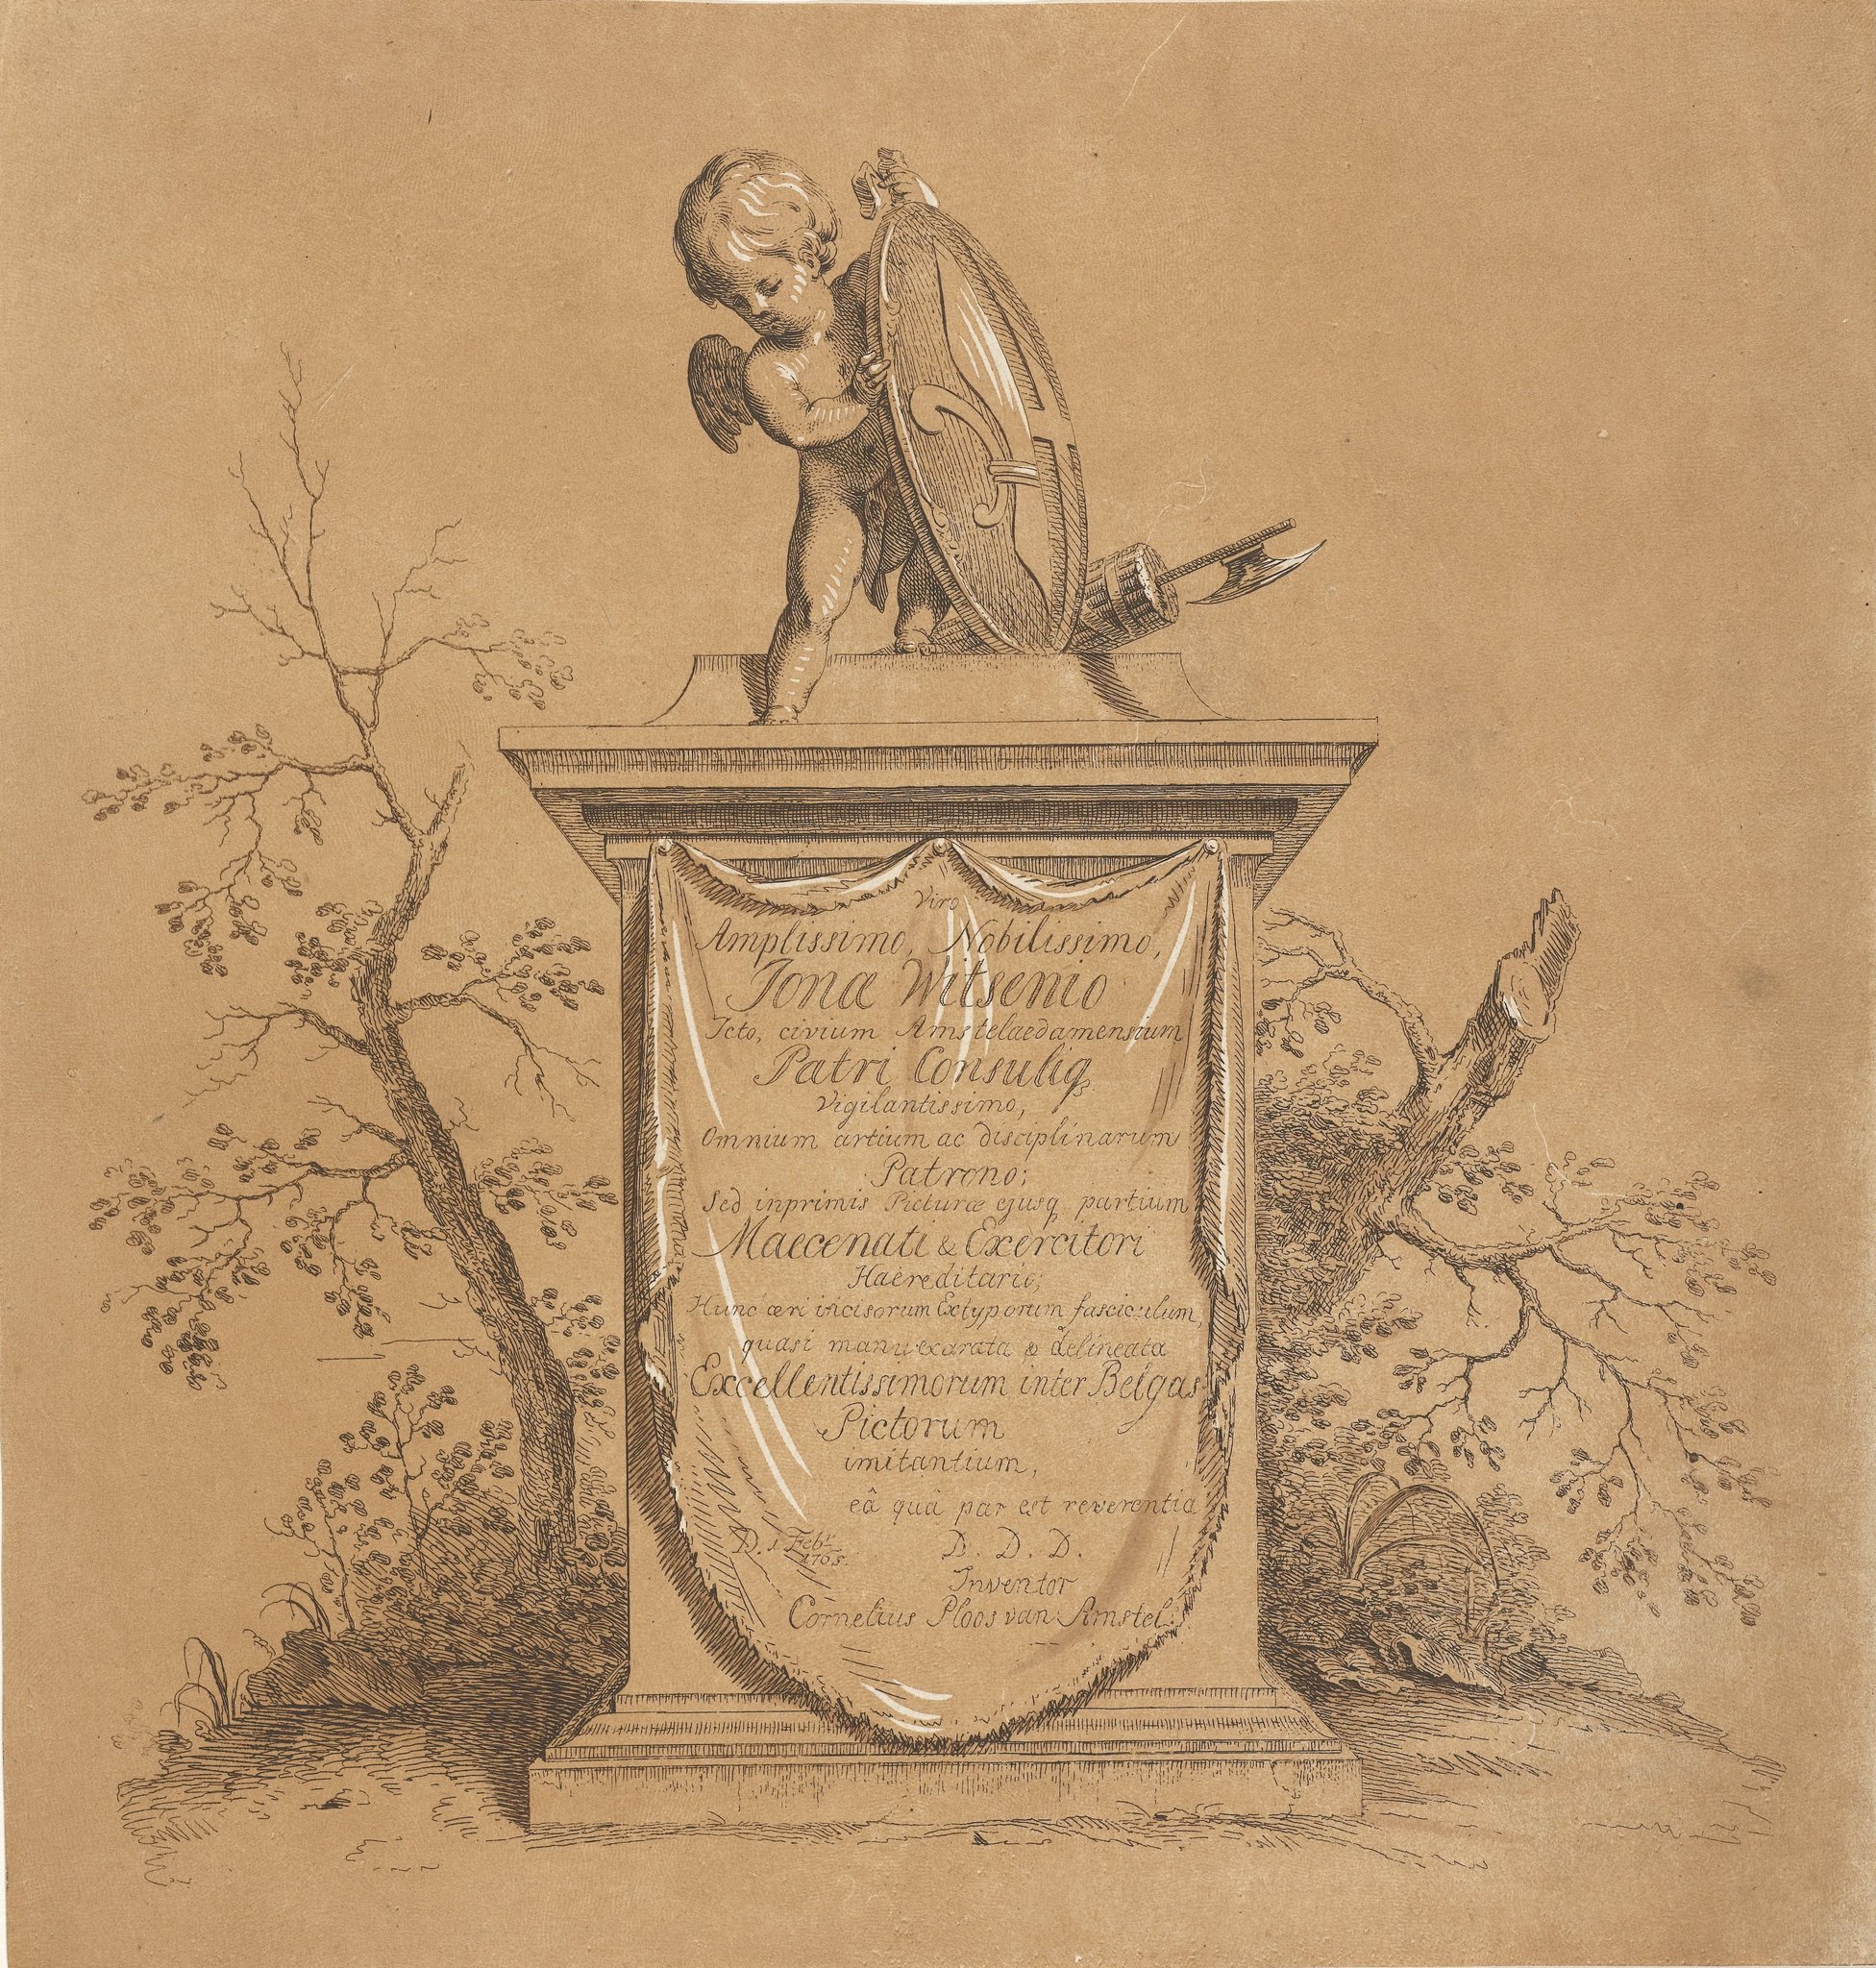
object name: print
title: Prentwerk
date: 1765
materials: paper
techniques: etching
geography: amsterdam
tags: monument, statue, cupids: 'amores', 'amoretti', 'putti'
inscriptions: collector's mark: Lugt 240, inscription: ‘Geoffreerd aan mijne vriend de Heer Jan Punt / Ploos v Amstel inv + fecit 1765’, collector's mark: Lugt 2725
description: Monument met bovenop een staande putto, die een schild vasthoudt. Naast de putto een fasces.